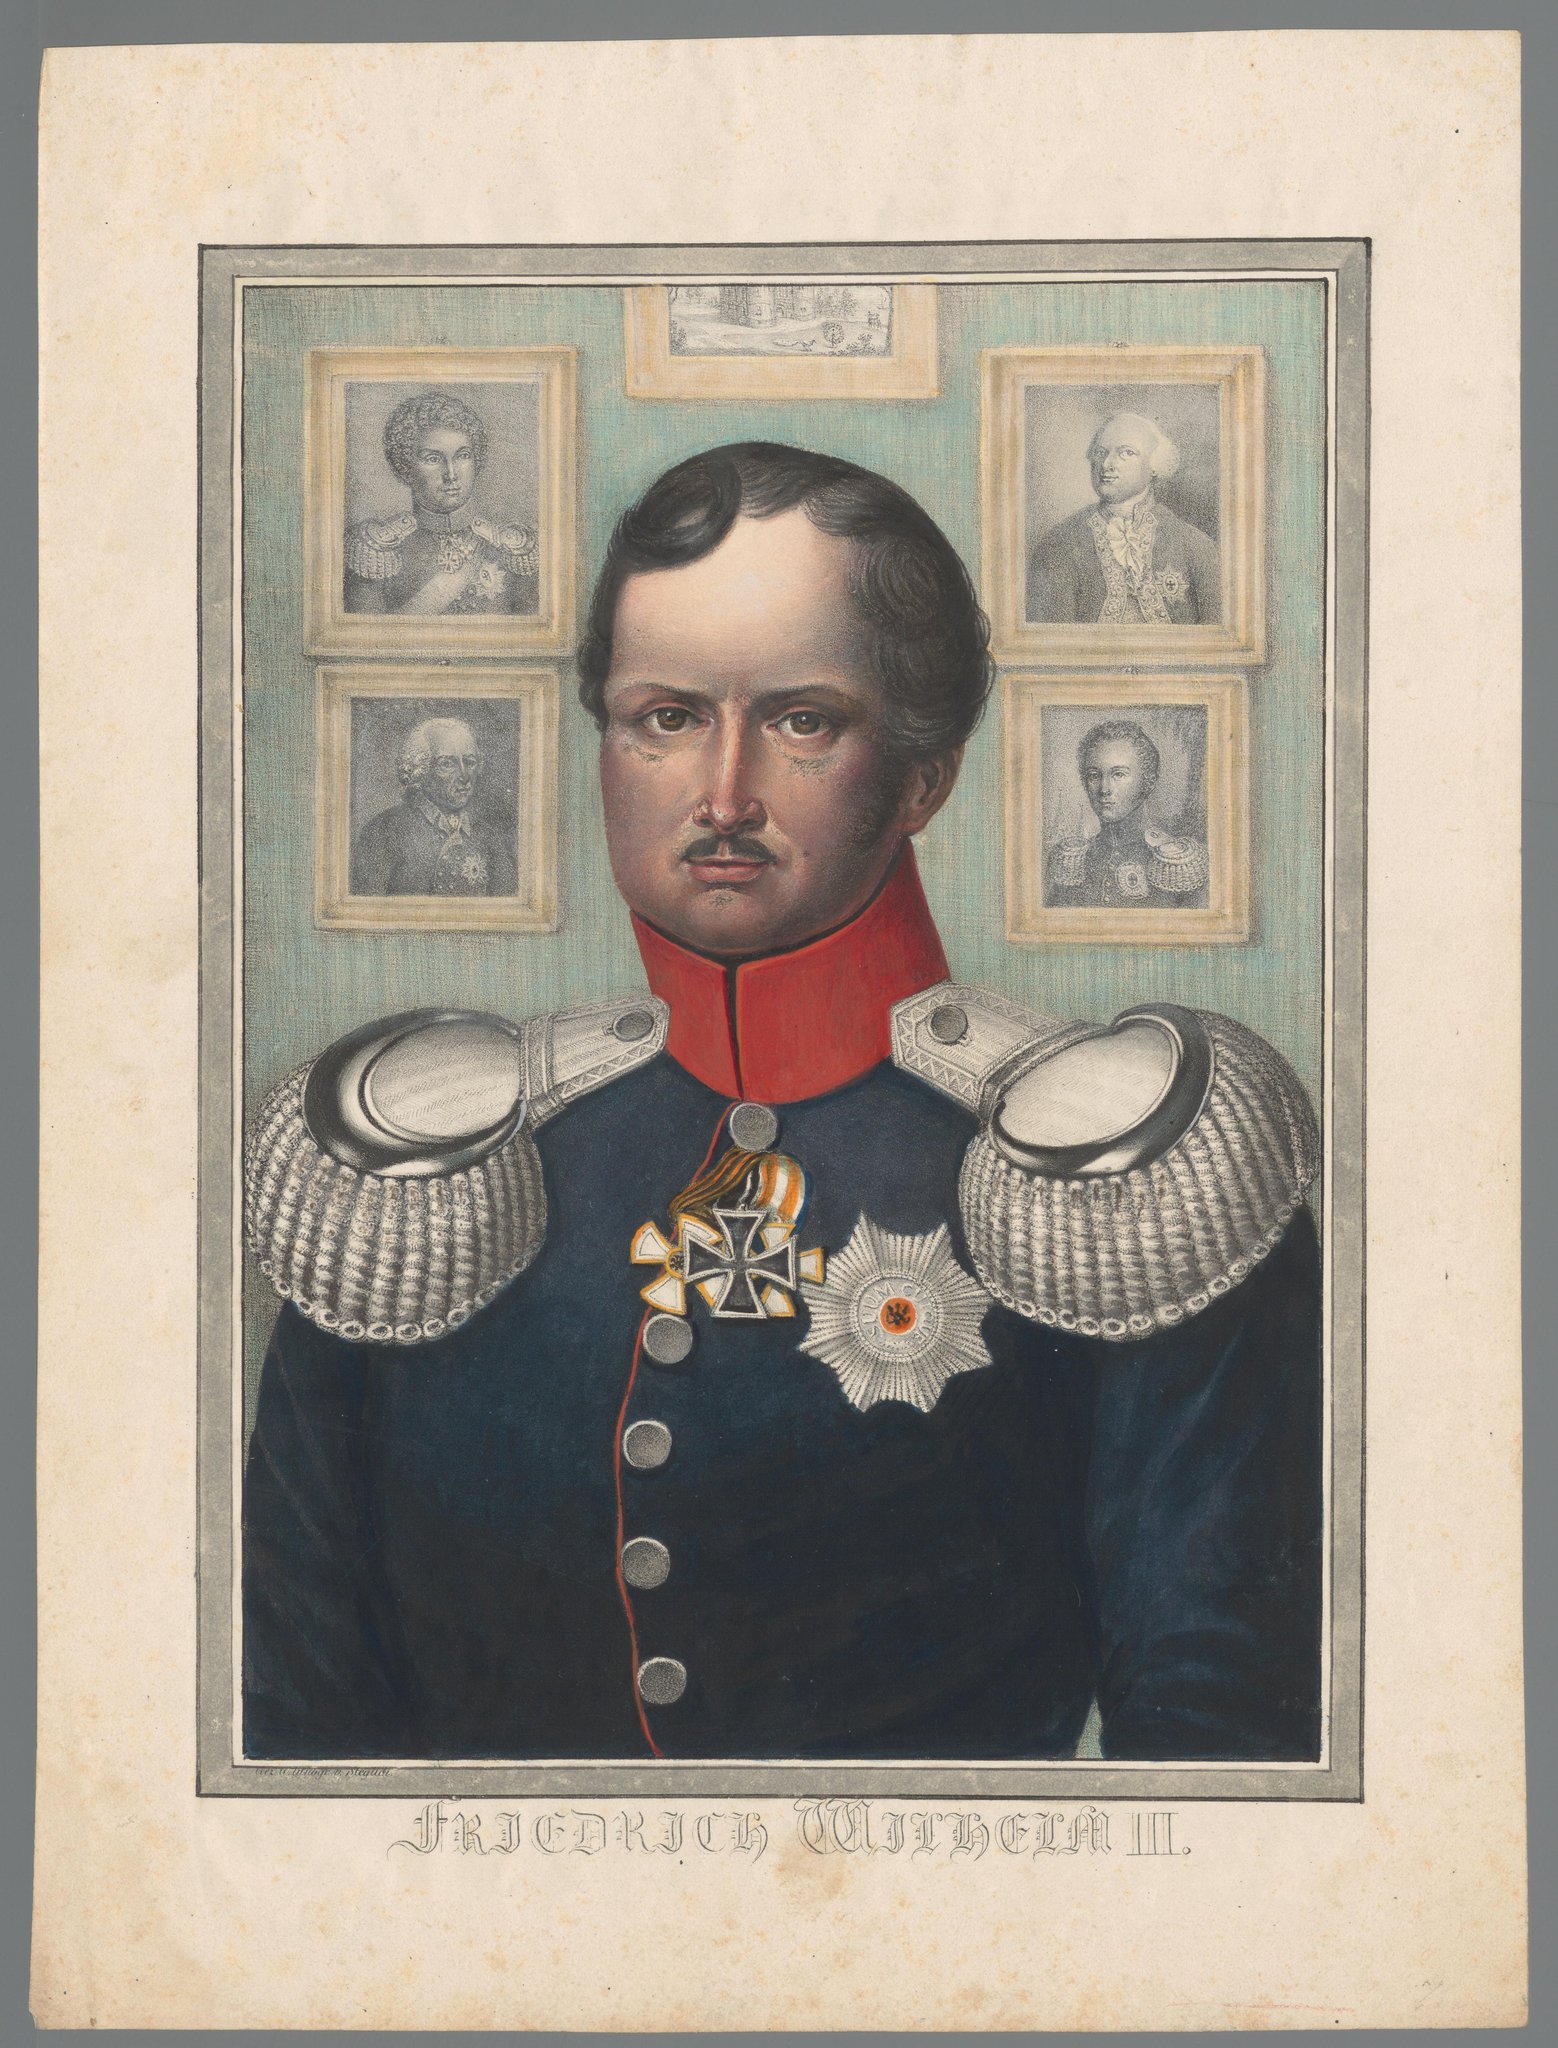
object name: print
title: Friedrich Wilhelm III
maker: steglich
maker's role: print maker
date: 1820-1875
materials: paper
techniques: hand coloring, lithograph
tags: frederik willem iii koning van pruisen, adult man, historical persons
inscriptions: collector's mark: Lugt 2228